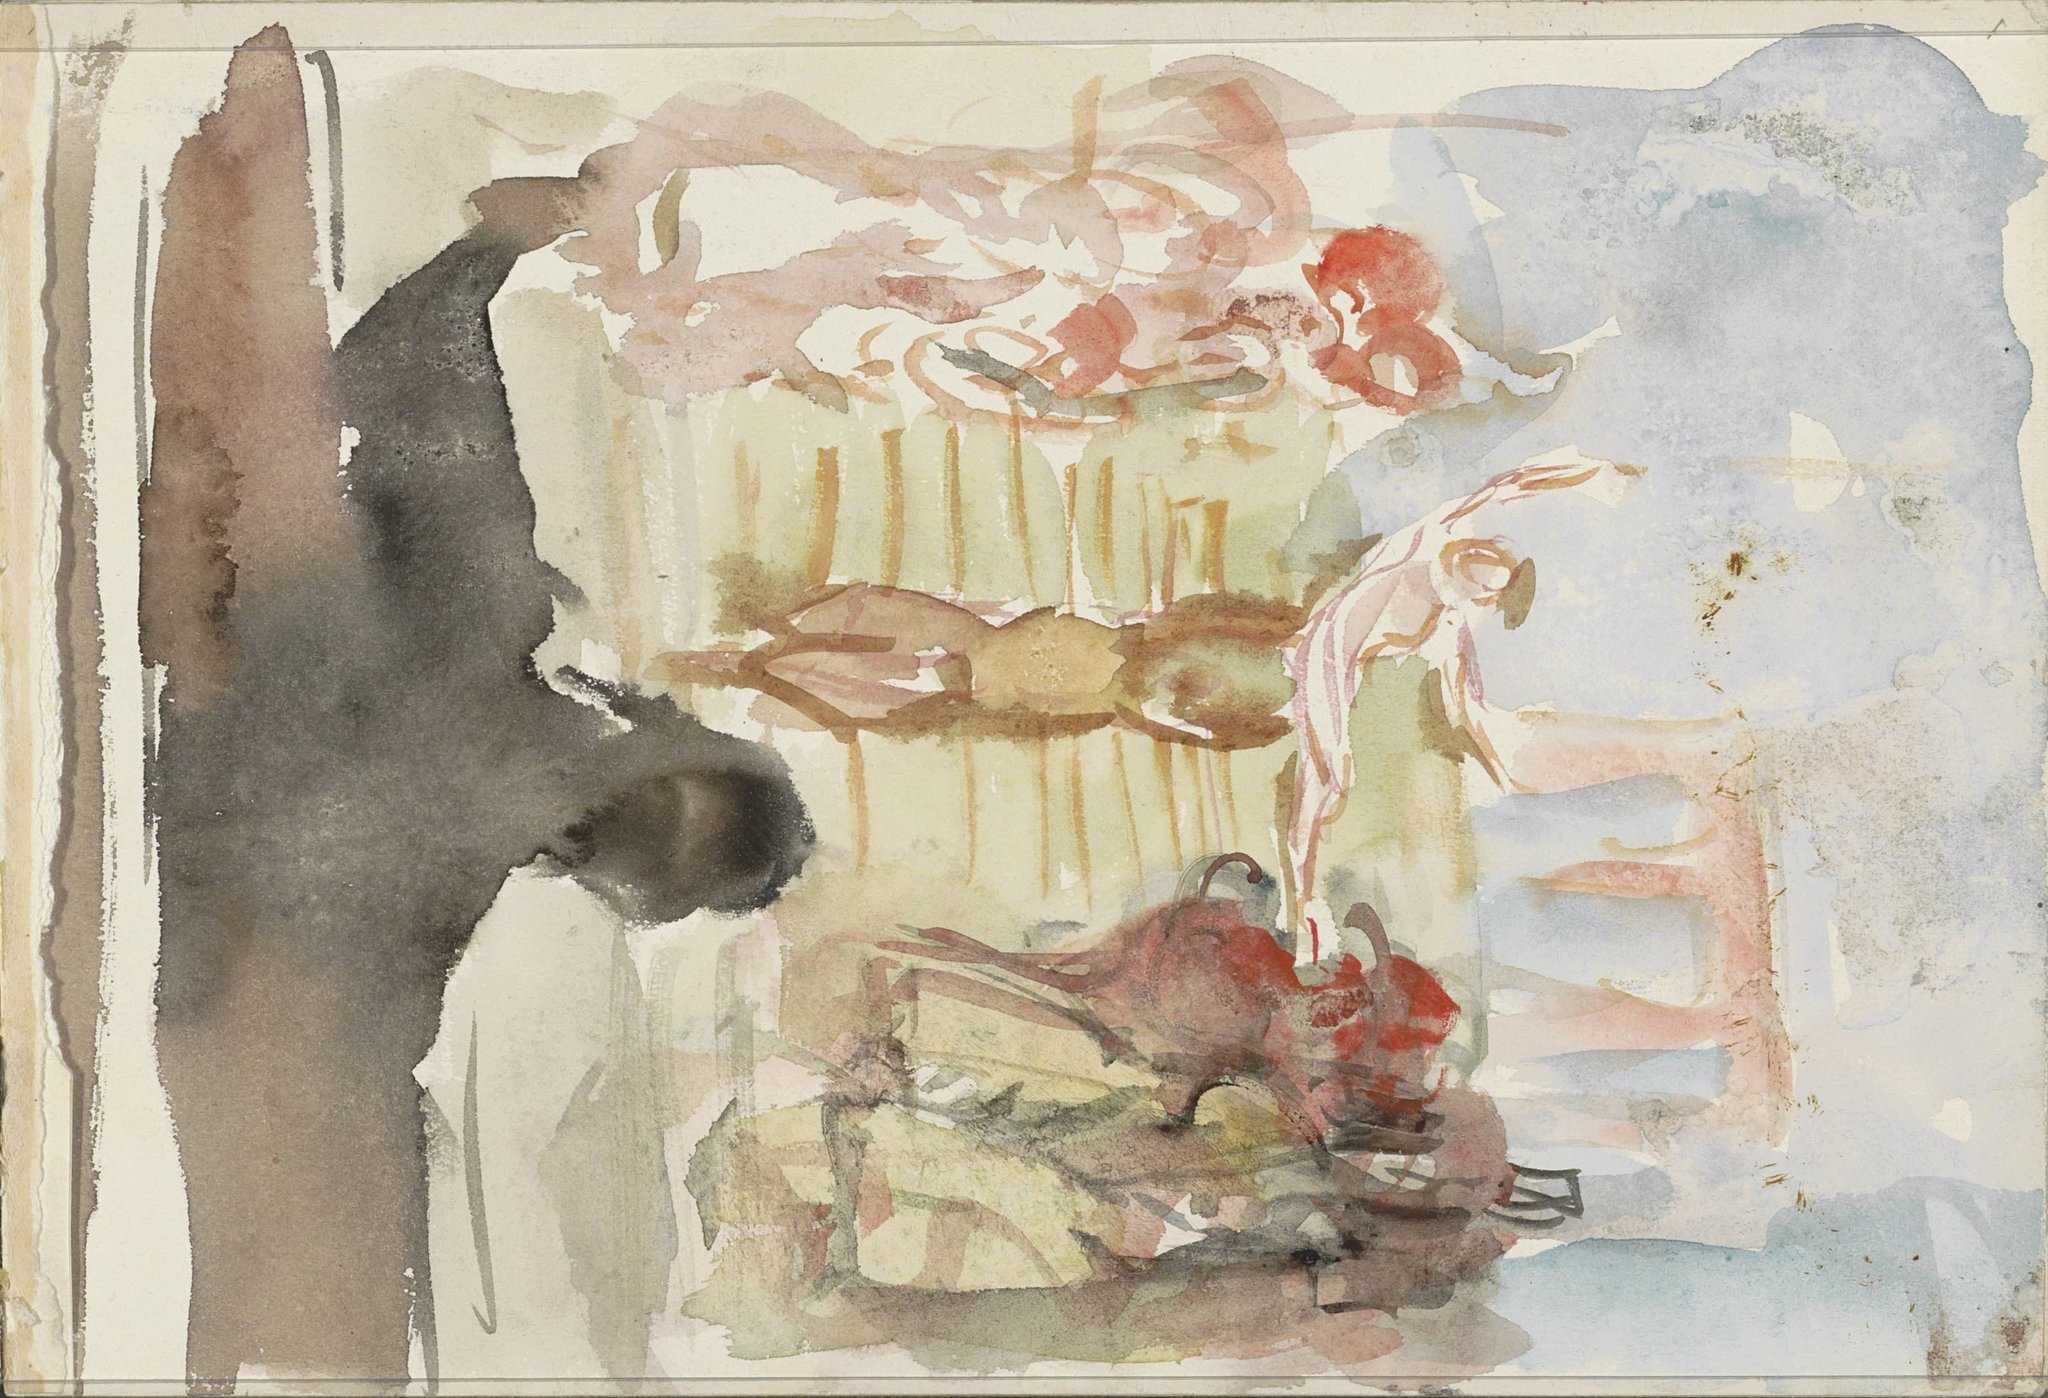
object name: sketchbook leaf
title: Theatervoorstelling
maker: isaac israels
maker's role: draughtsman, painter, print maker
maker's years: 1865-1934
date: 1875-1934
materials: paper, watercolor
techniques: brush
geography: the hague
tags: theatre, theatrical performance, conductor ~ music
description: Op het toneel dansers of acrobaten. Vooraan de dirigent in de orkestbak. Blad 1 recto uit schetsboek XXVIII met 17 bladen.